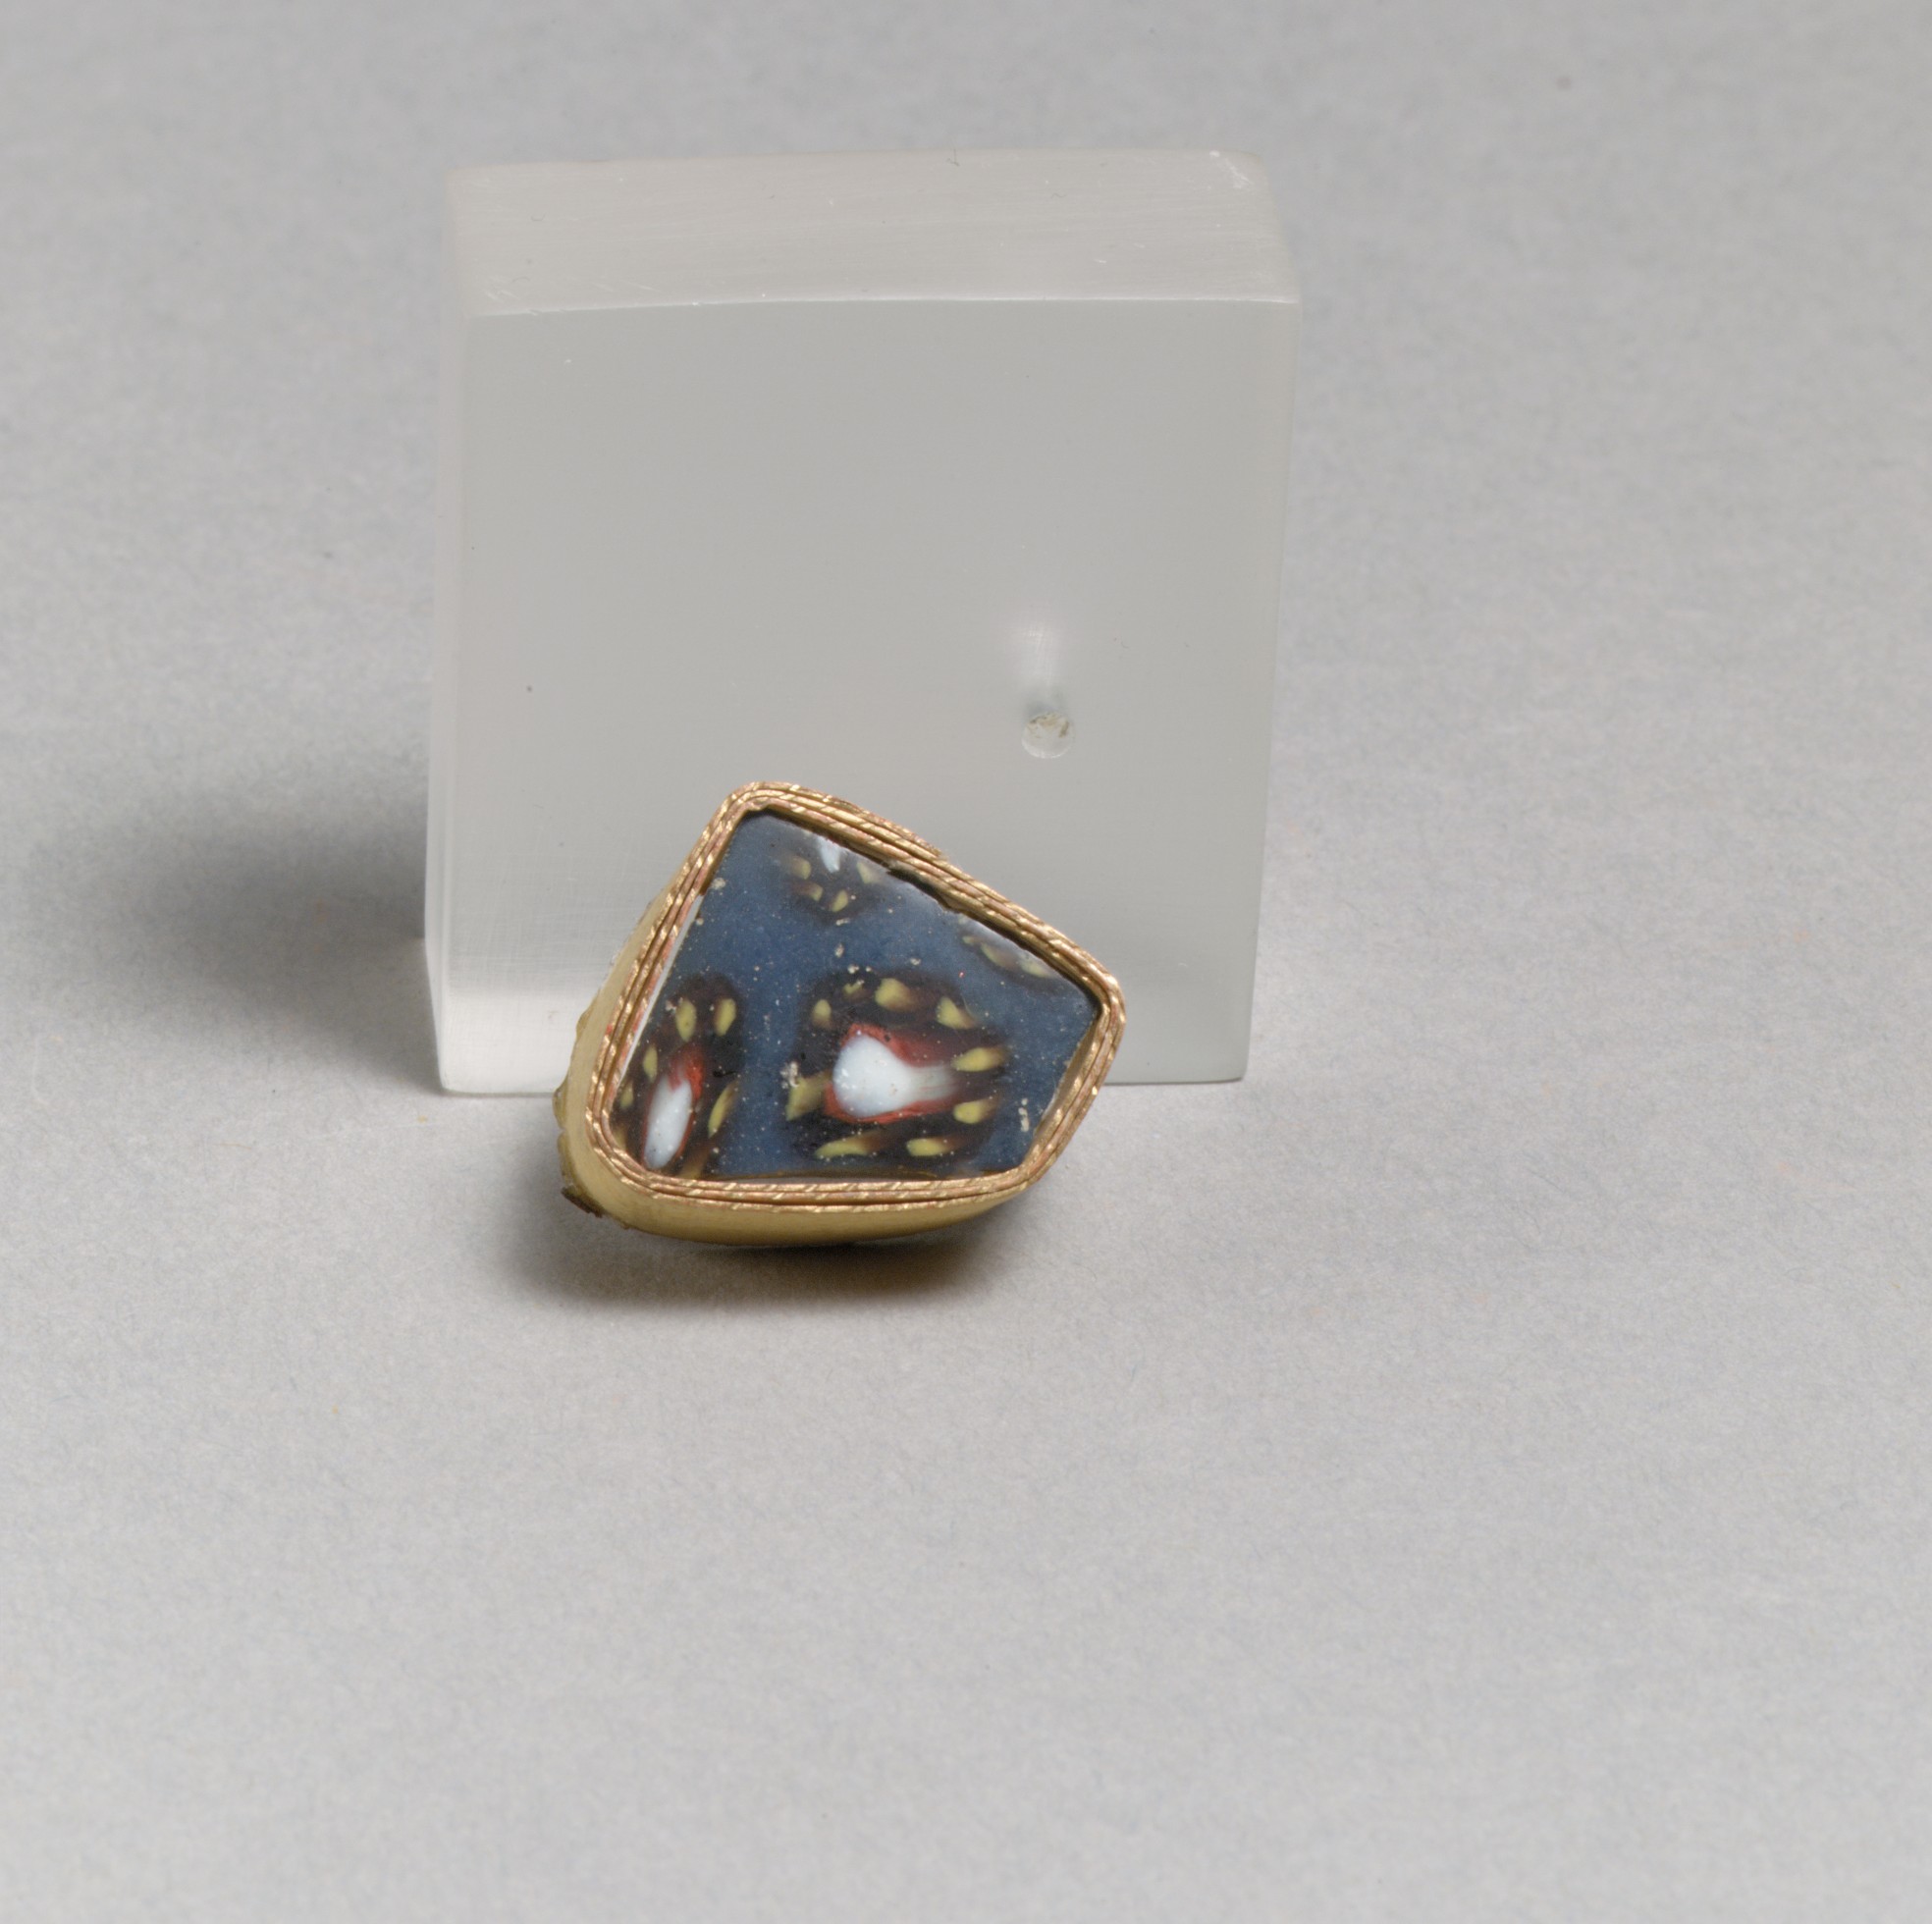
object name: fragment, mosaic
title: Glass mosaic fragment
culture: roman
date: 34 BCE-33 CE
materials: glass